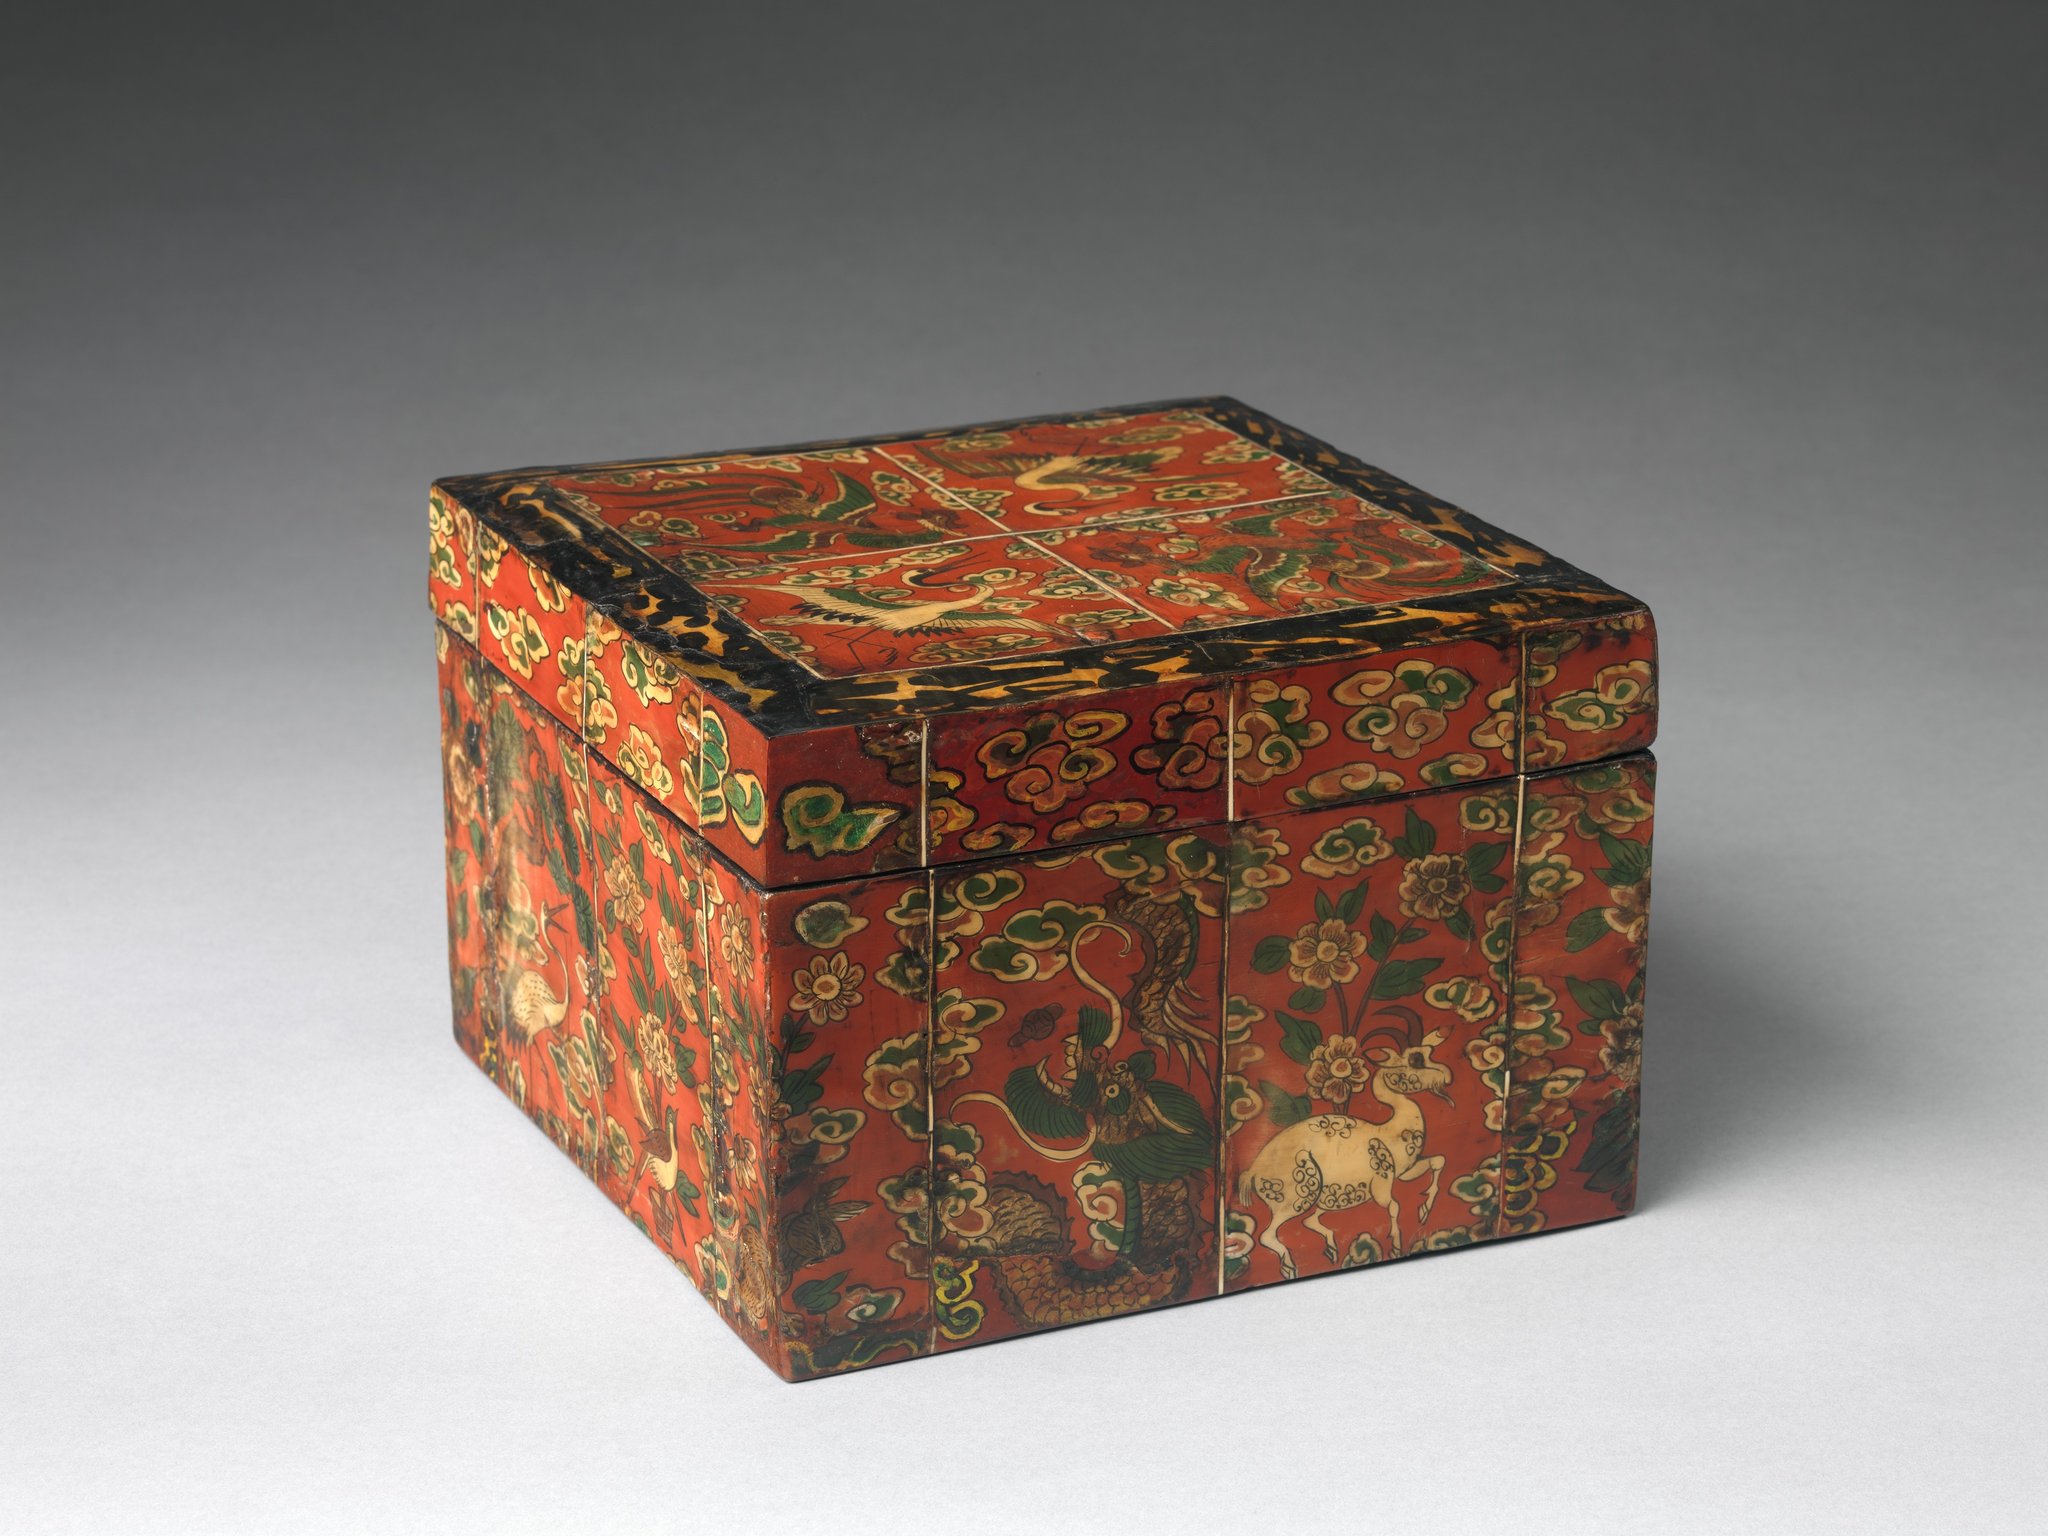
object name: box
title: Box decorated with auspicious symbols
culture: korean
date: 1801-1900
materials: horn, wood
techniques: inlay, lacquer, painting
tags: cranes,dragons,deer,flowers